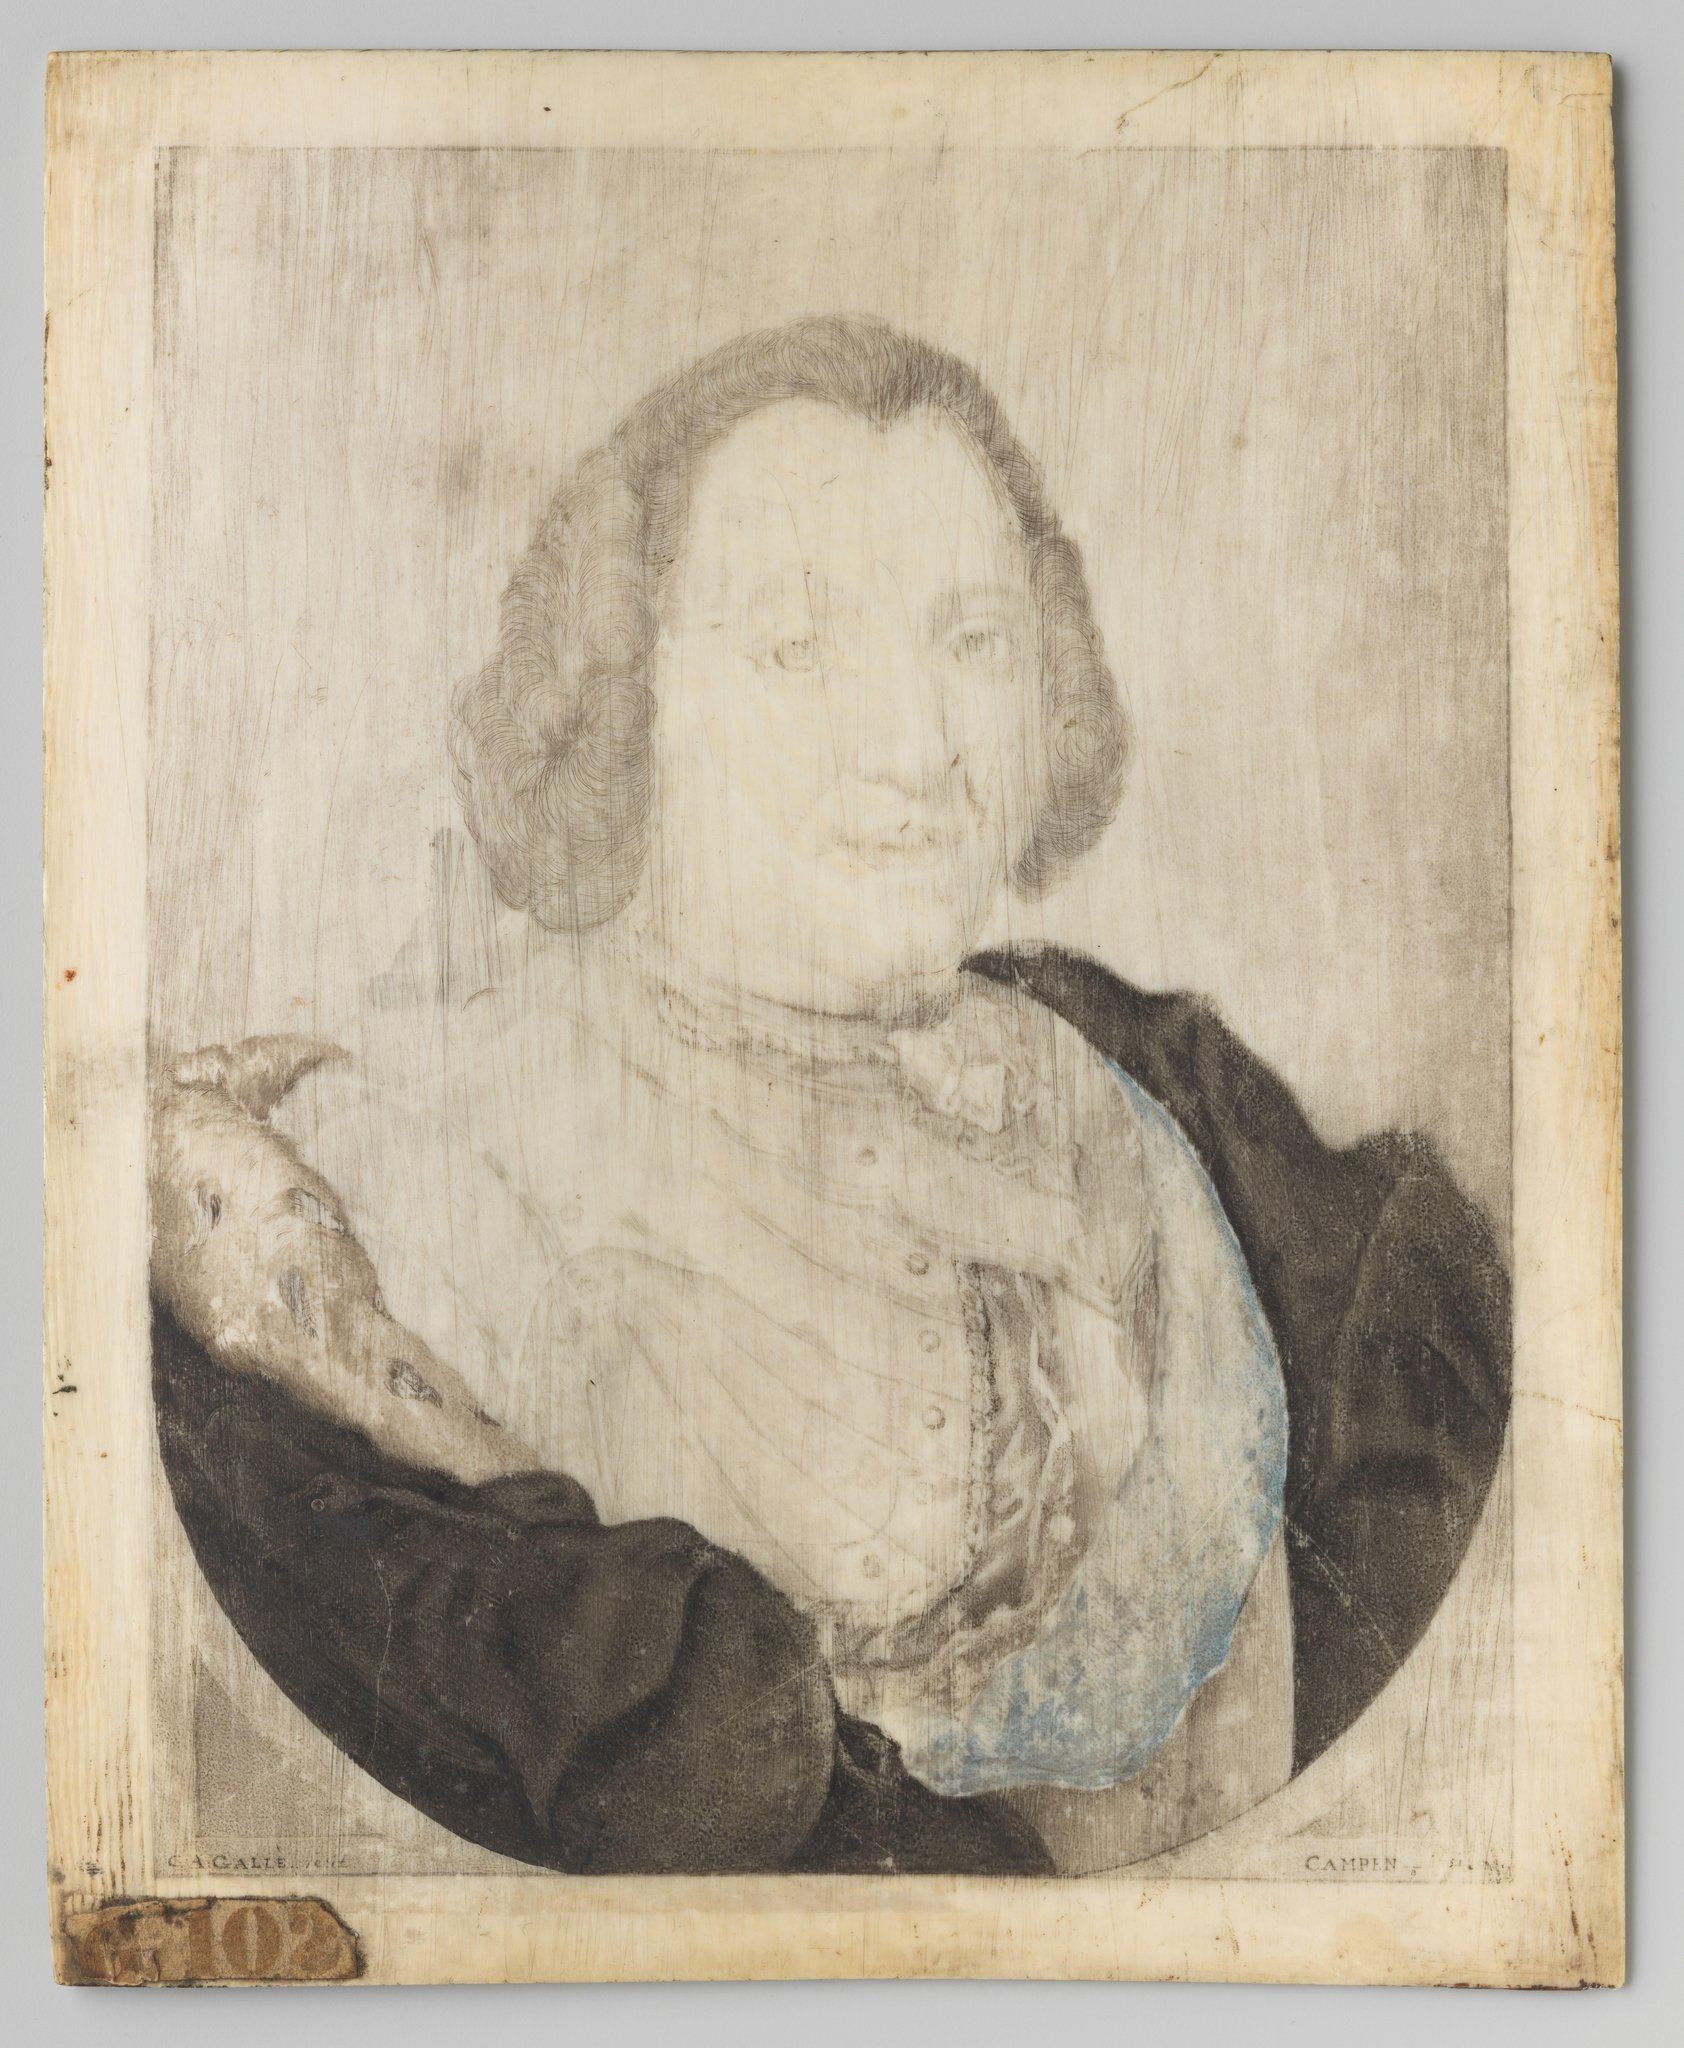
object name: plaque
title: Gravure op ivoor. Portret van een man.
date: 1700-1800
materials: ivory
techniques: engraving